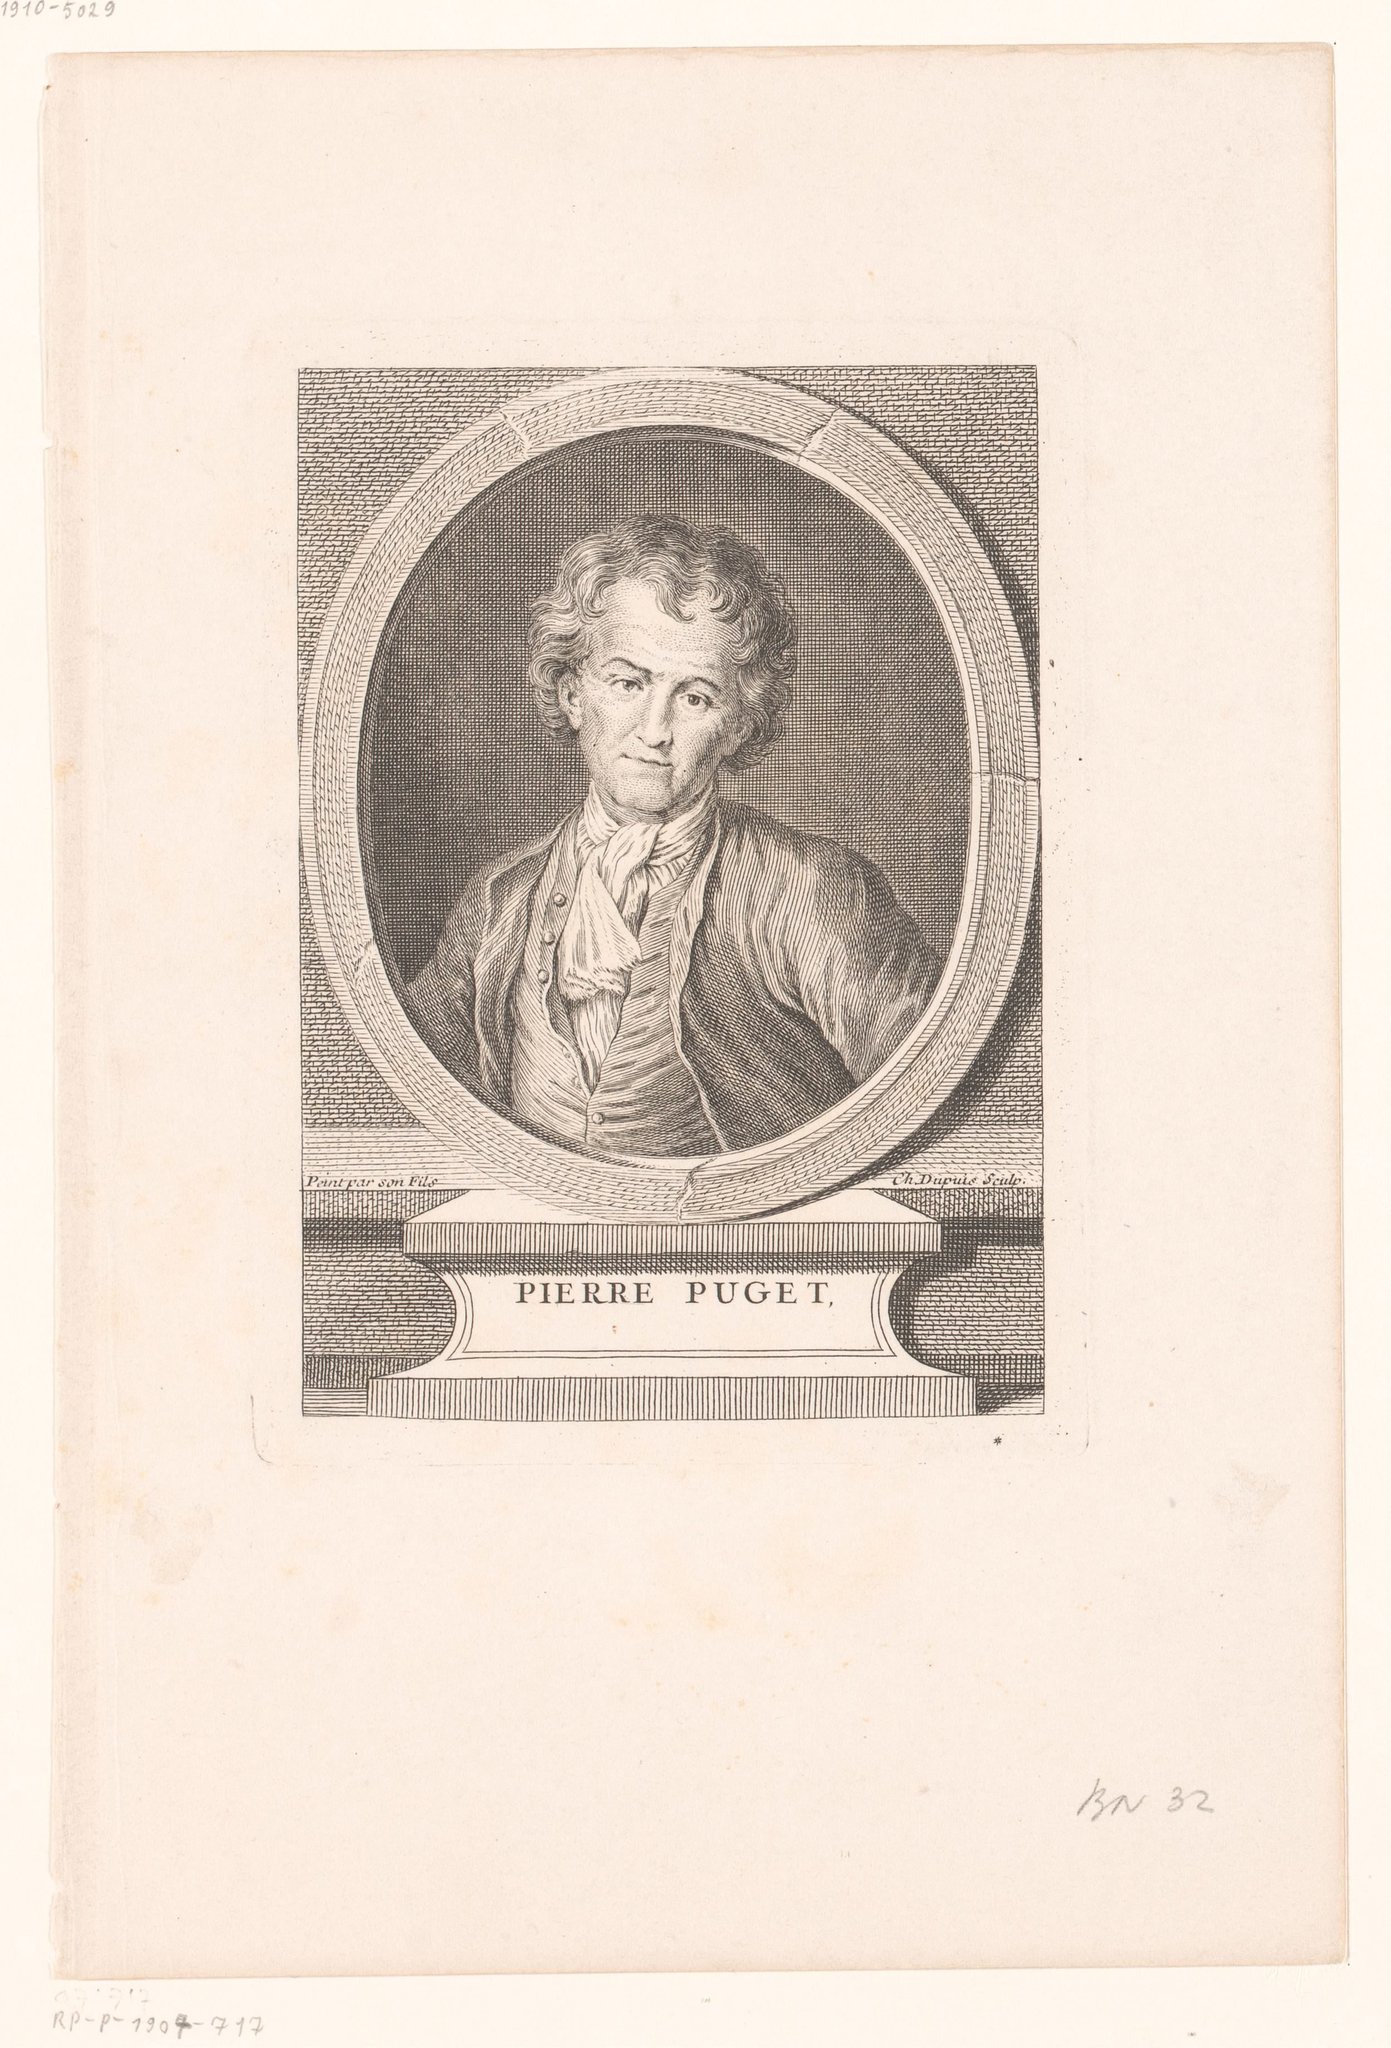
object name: print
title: Iandaimen Bogaerdt, onderweghe Sloterdyck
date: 1596-1630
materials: paper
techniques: etching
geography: amsterdam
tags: castle, fishing (sports), orchard, sloterdijk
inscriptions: address: ‘I. Ottens exc.’, collector's mark: Lugt 2228, caption: ‘IANDAIMEN BOGAERDT, Onderweghe SLOTERDYCK’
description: Gezicht op het landhuis met bijgebouwen en de boomgaard van Jan Daimen. Op de voorgrond twee hengelaars, met netten vissend in de gracht. Een ruiter komt aanrijden. Op het tweede plan een houten bruggetje, waarachter de boomgaard. Het dak van het landhuis is te zien tussen de bomen.